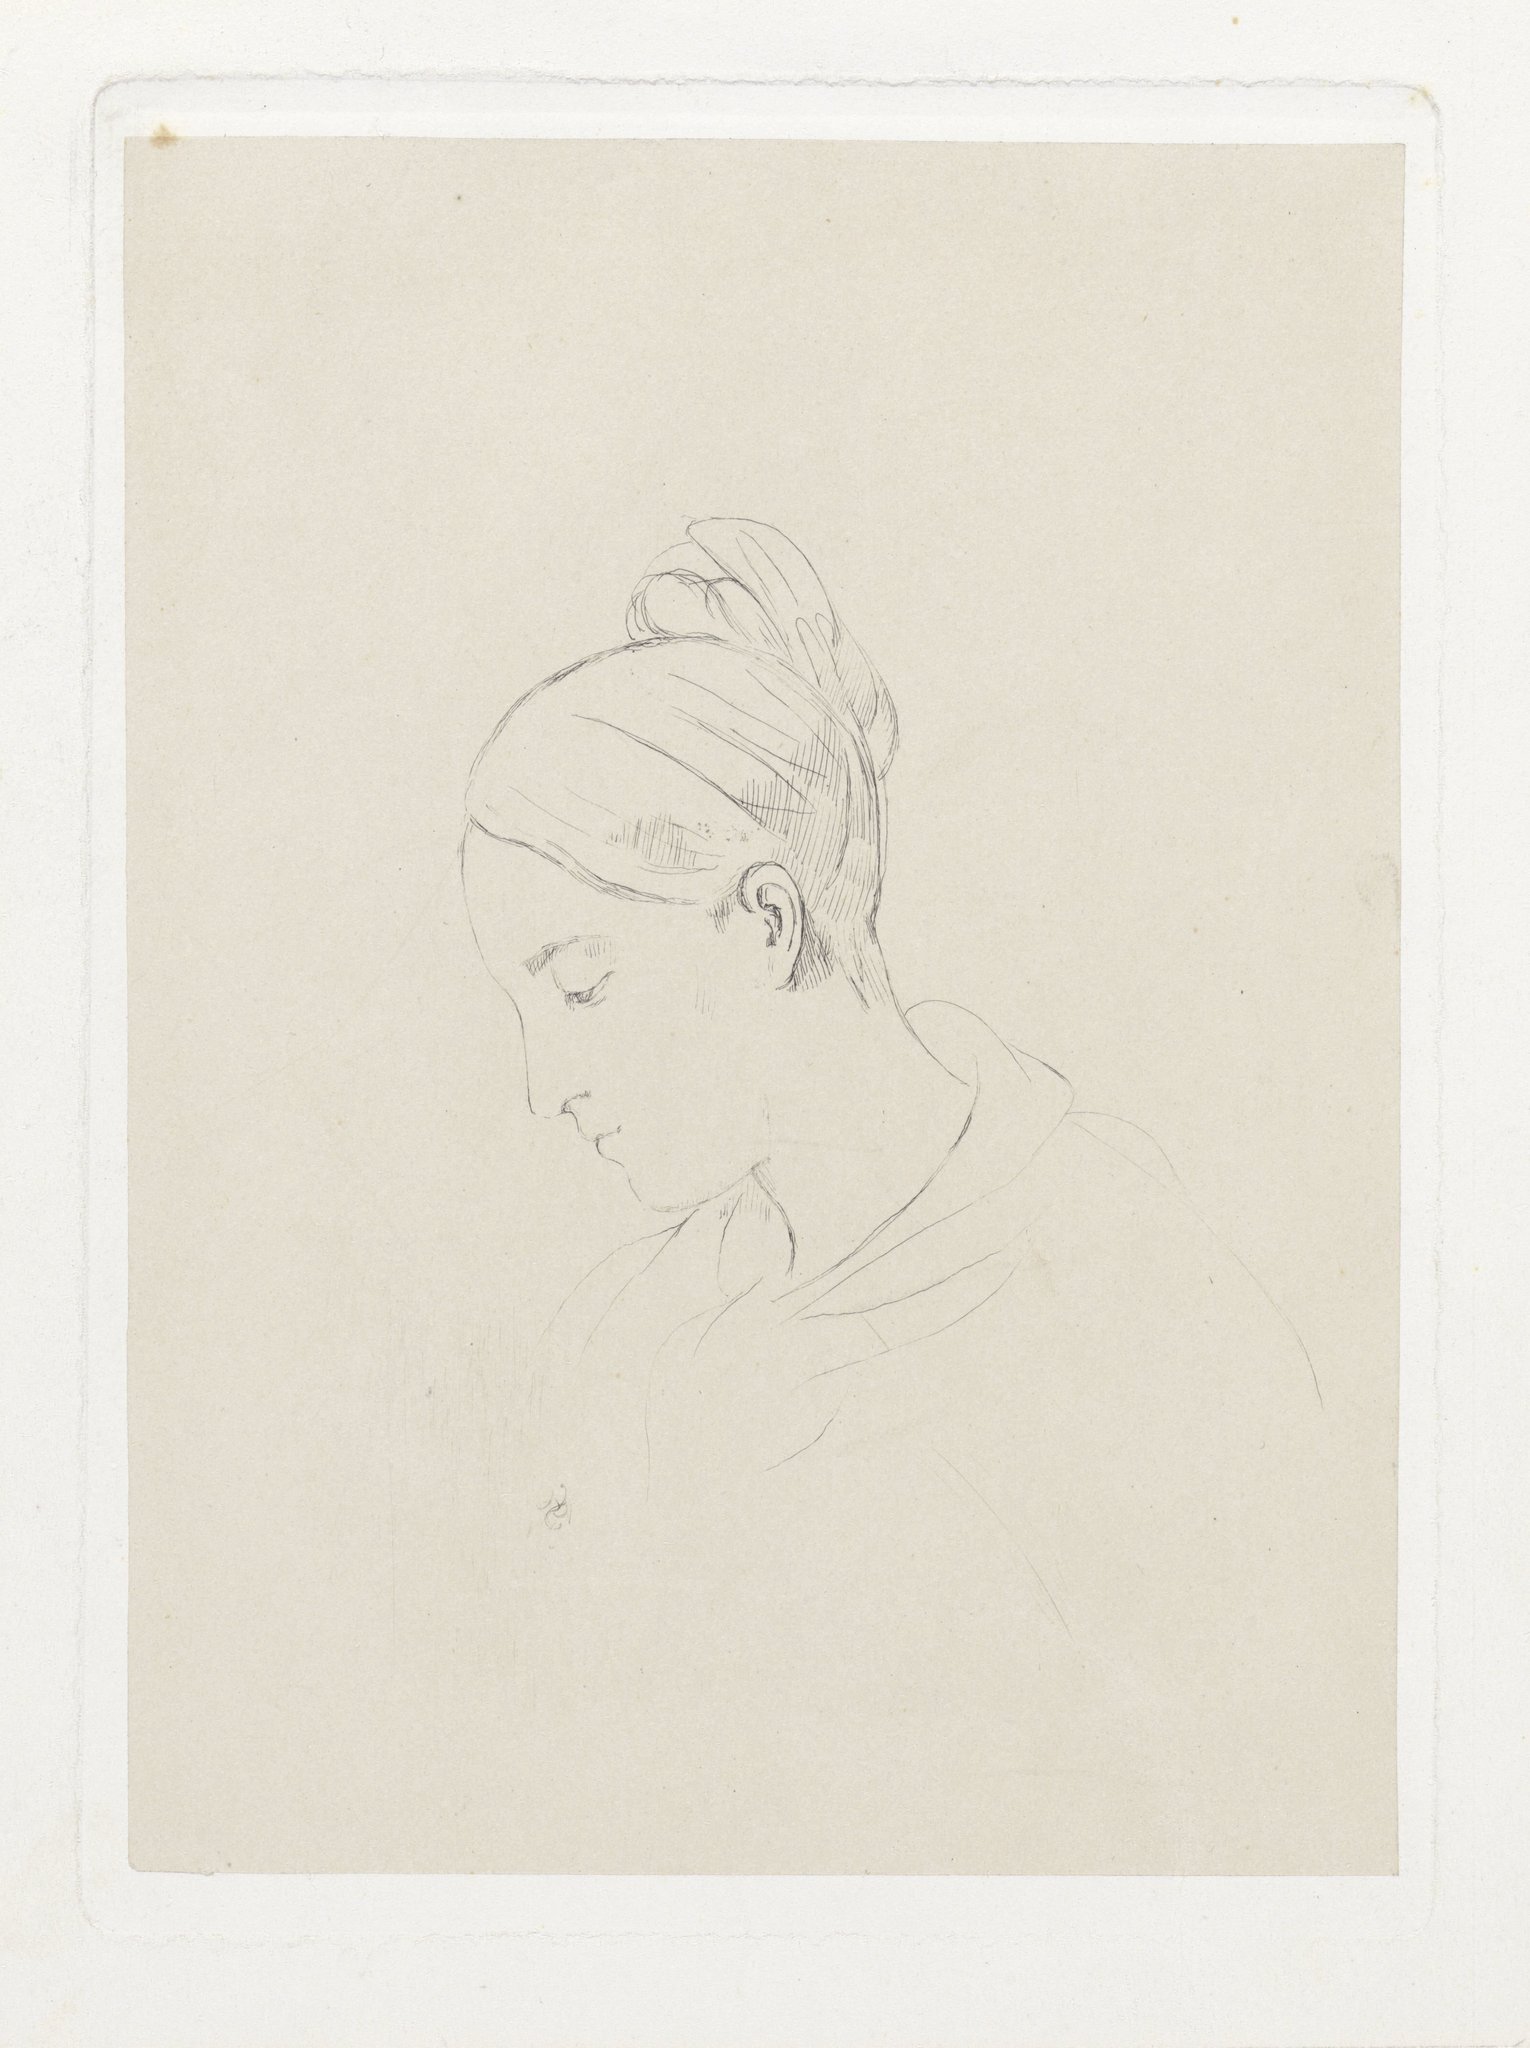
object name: print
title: Hoofd van een jonge vrouw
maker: cornelia marjolin-scheffer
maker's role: draughtsman, sculptor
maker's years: 1830-1899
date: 1845-1899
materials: paper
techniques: etching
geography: paris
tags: head bent forward; bowing - aa - female human figure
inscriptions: collector's mark: Lugt 138, collector's mark: Lugt 2760, collector's mark: Lugt 2228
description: Hoofd van een jonge vrouw met een hoofddoek. Ze heeft haar ogen neergeslagen en buigt haar hoofd licht voorover.